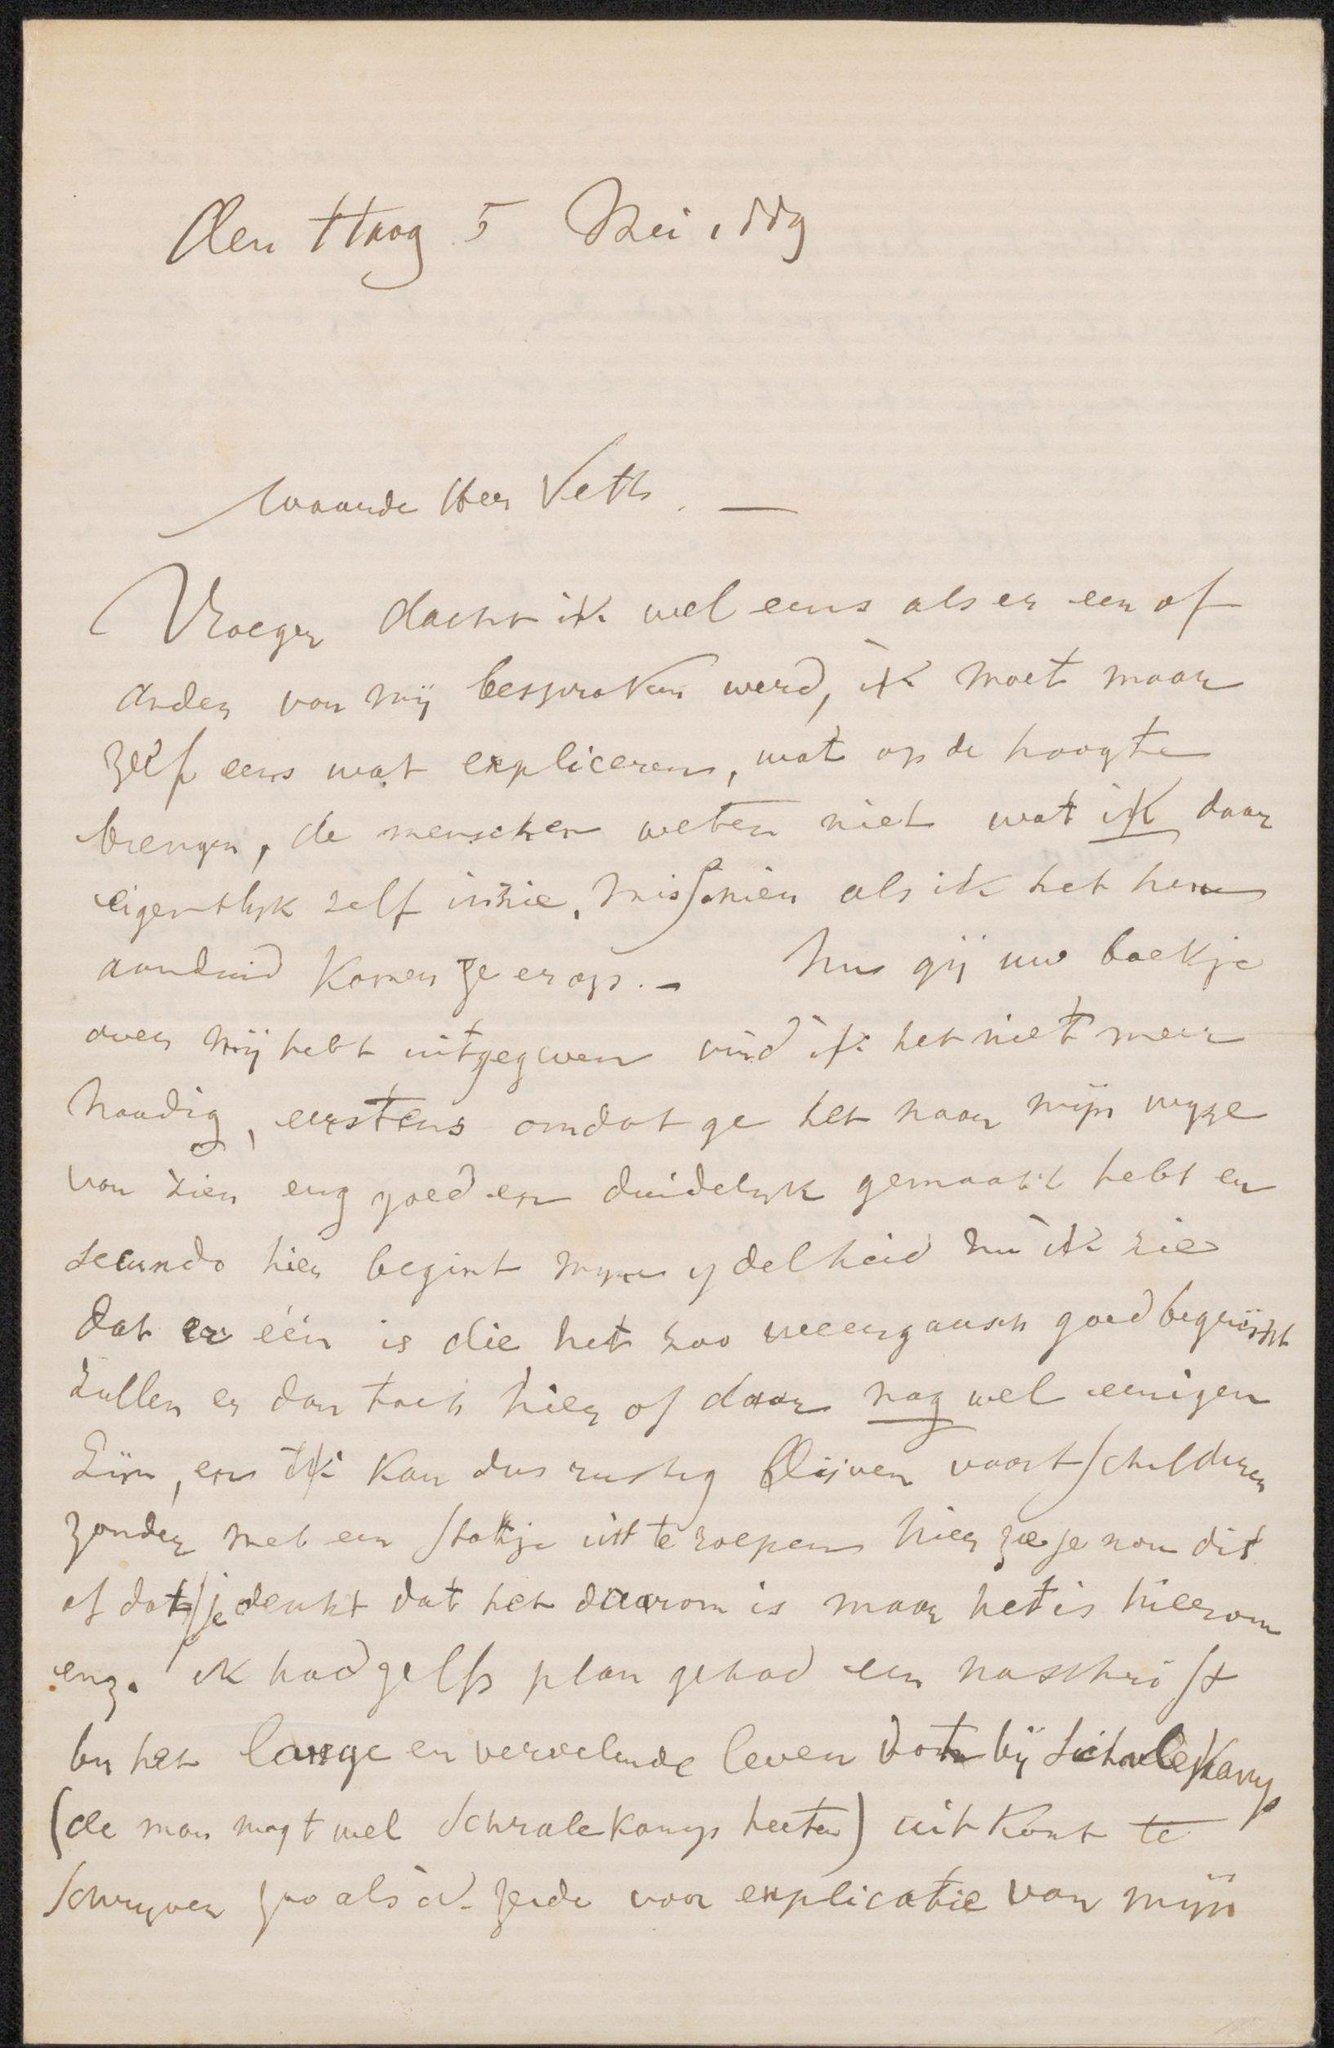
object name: letter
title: Brief aan Jan Veth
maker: jozef israëls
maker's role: draughtsman, painter, print maker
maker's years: 1824-1911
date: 1889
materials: ink, paper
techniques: pen, writing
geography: the hague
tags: amsterdam, designer, jan veth, utrecht, publisher, johan marinus schalekamp, rijksmuseum amsterdam, painting (including book-illumination, miniature-painting), printed matter, paris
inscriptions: collector's mark: ‘RPK’